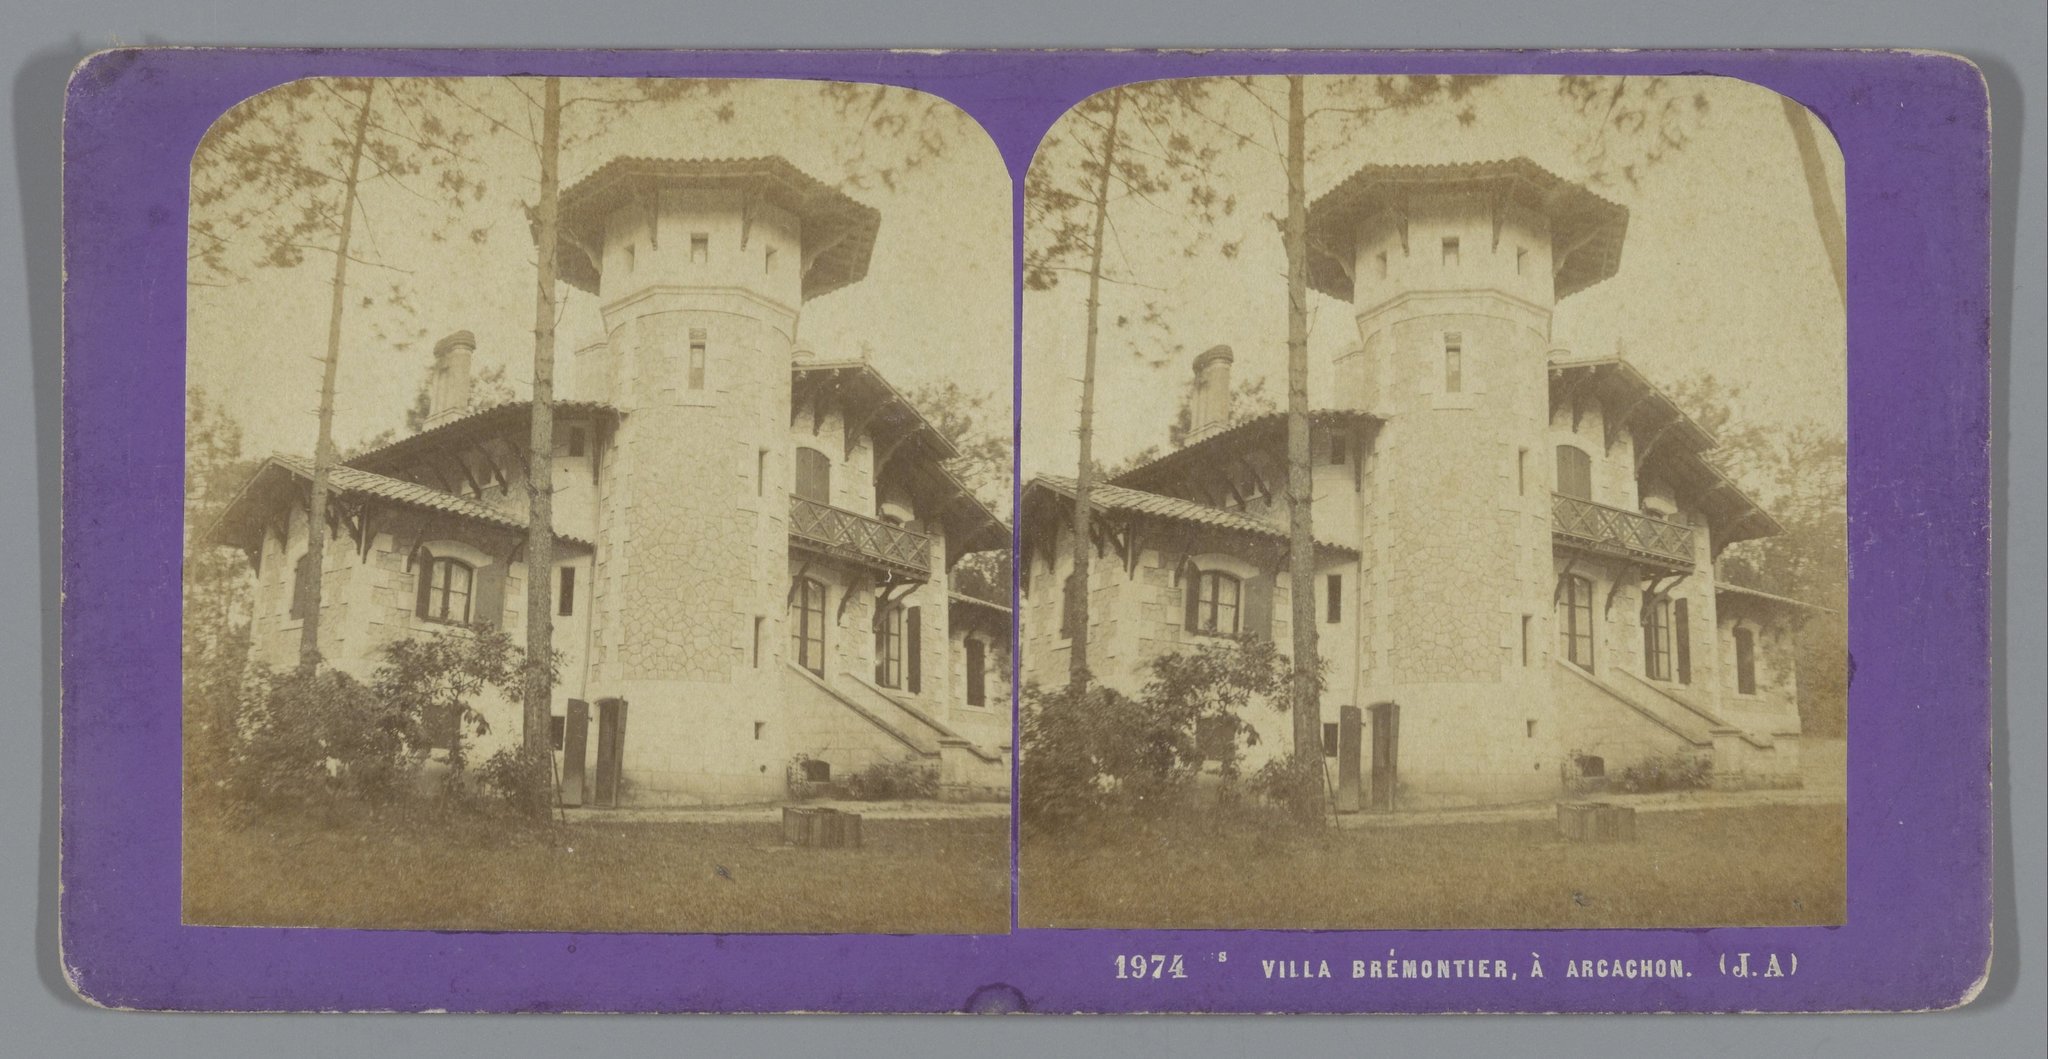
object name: stereograph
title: Villa Brémontier, à Arcachon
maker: jean andrieu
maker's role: fotograaf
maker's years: 1816-1872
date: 1862-1876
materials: cardboard, photographic support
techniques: albumen print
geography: arcachon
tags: rural housing, e.g. country-house, villa, cottage, façade (of house or building)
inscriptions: number: ‘1974bis’